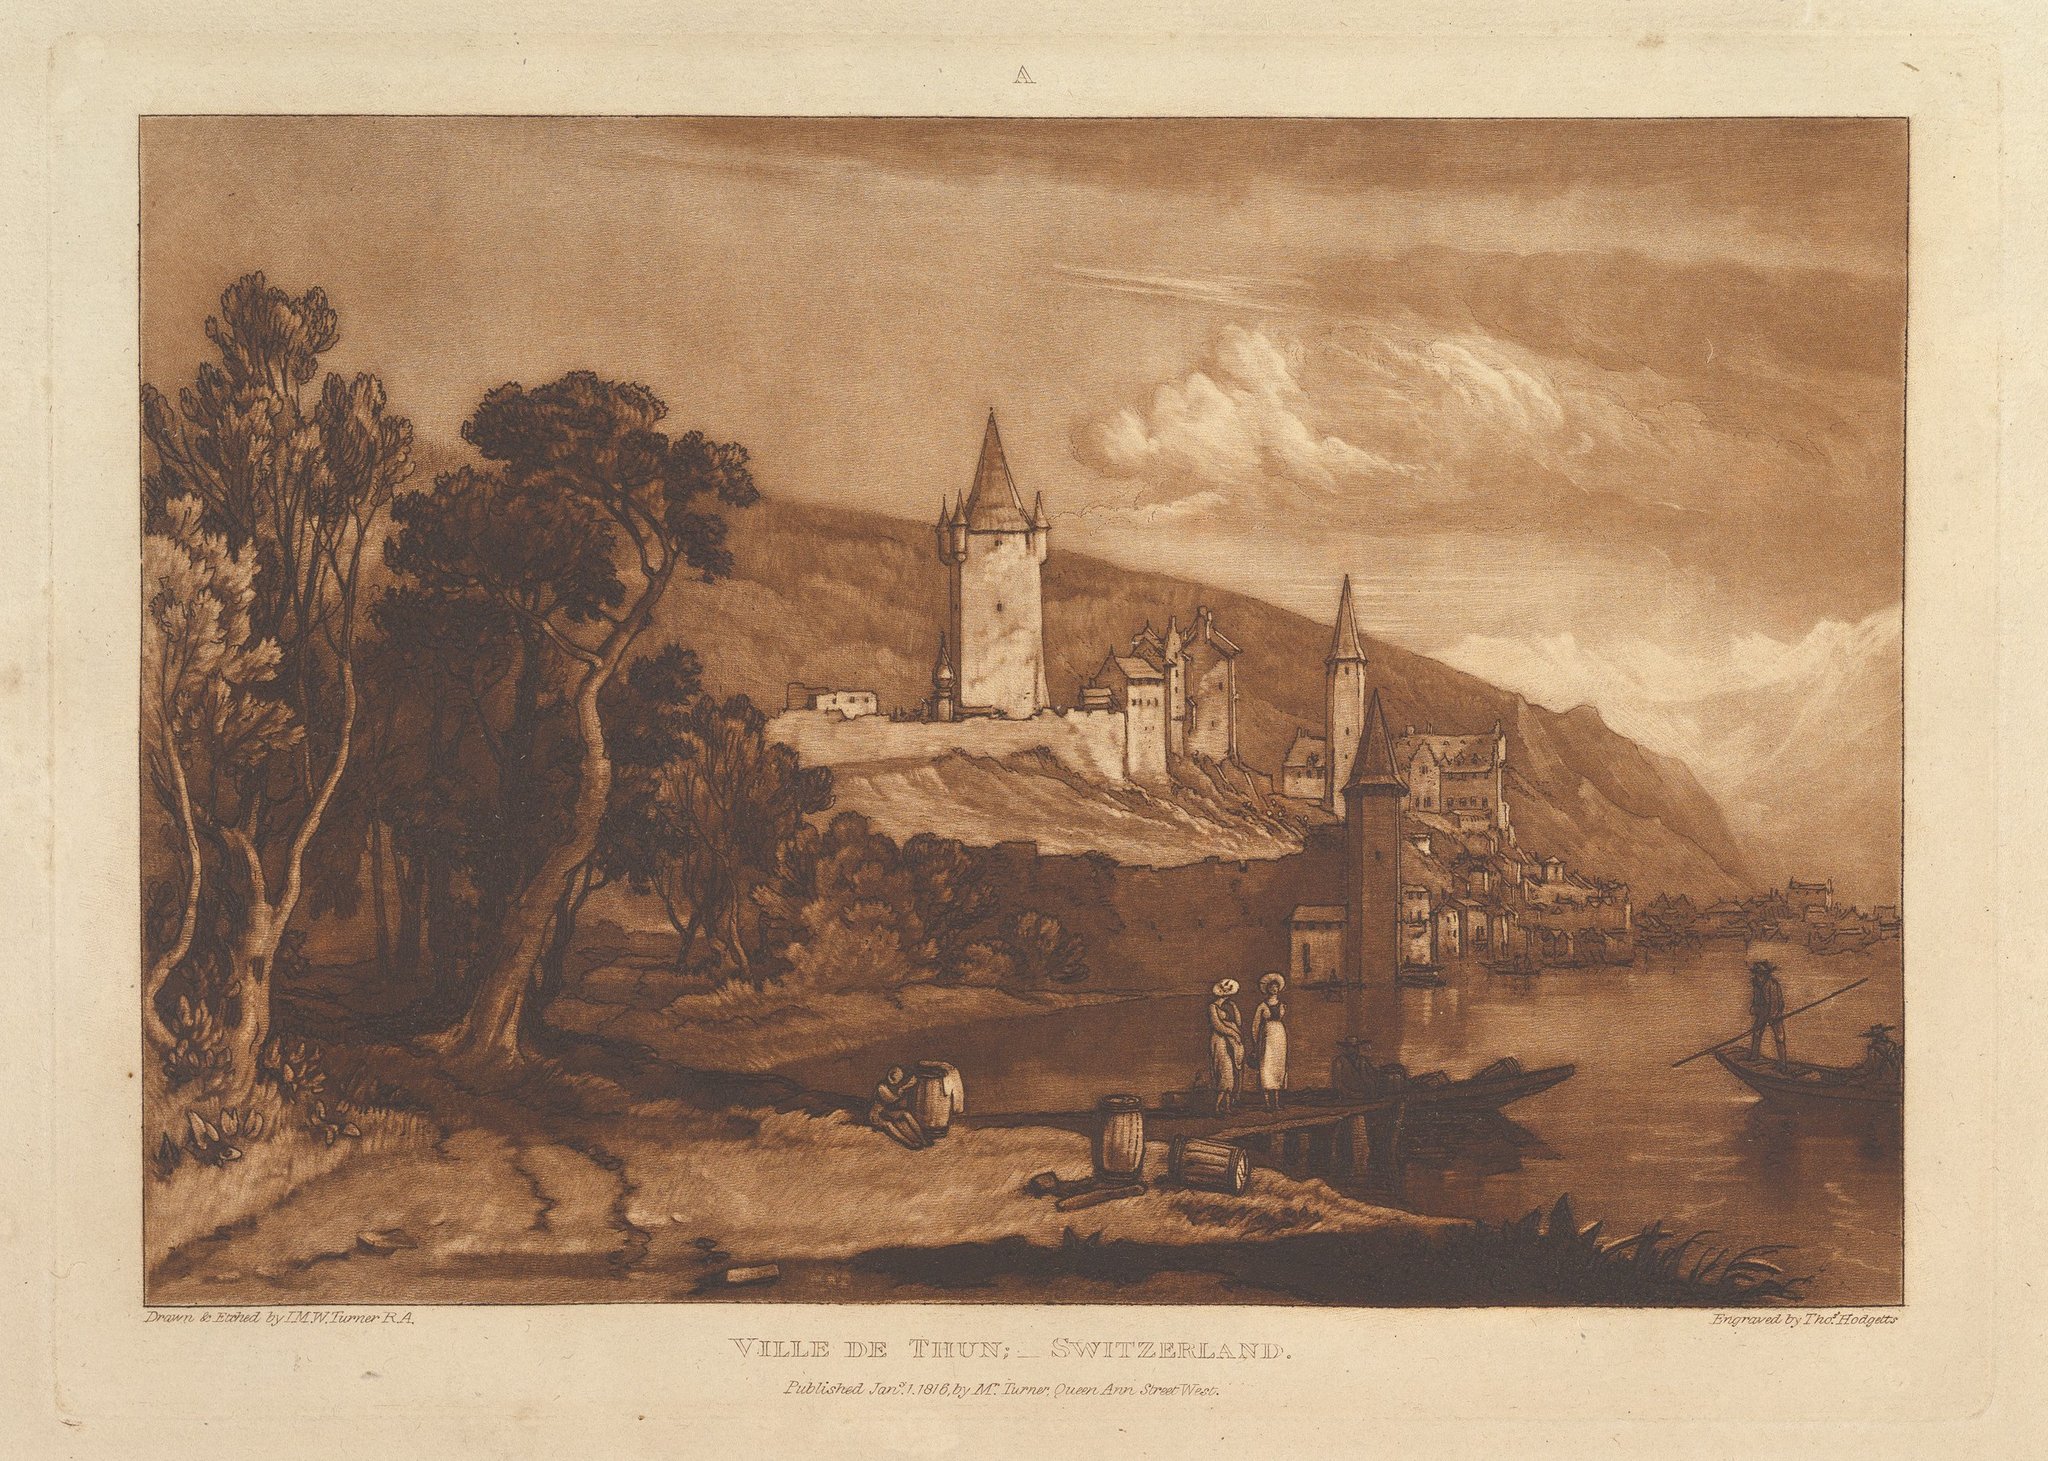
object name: print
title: Ville de Thun, Switzerland, part XII, plate 59 from "Liber Studiorum"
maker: joseph mallord william turner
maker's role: artist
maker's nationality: british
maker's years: 1775-1851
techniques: etching, mezzotint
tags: buildings,landscapes